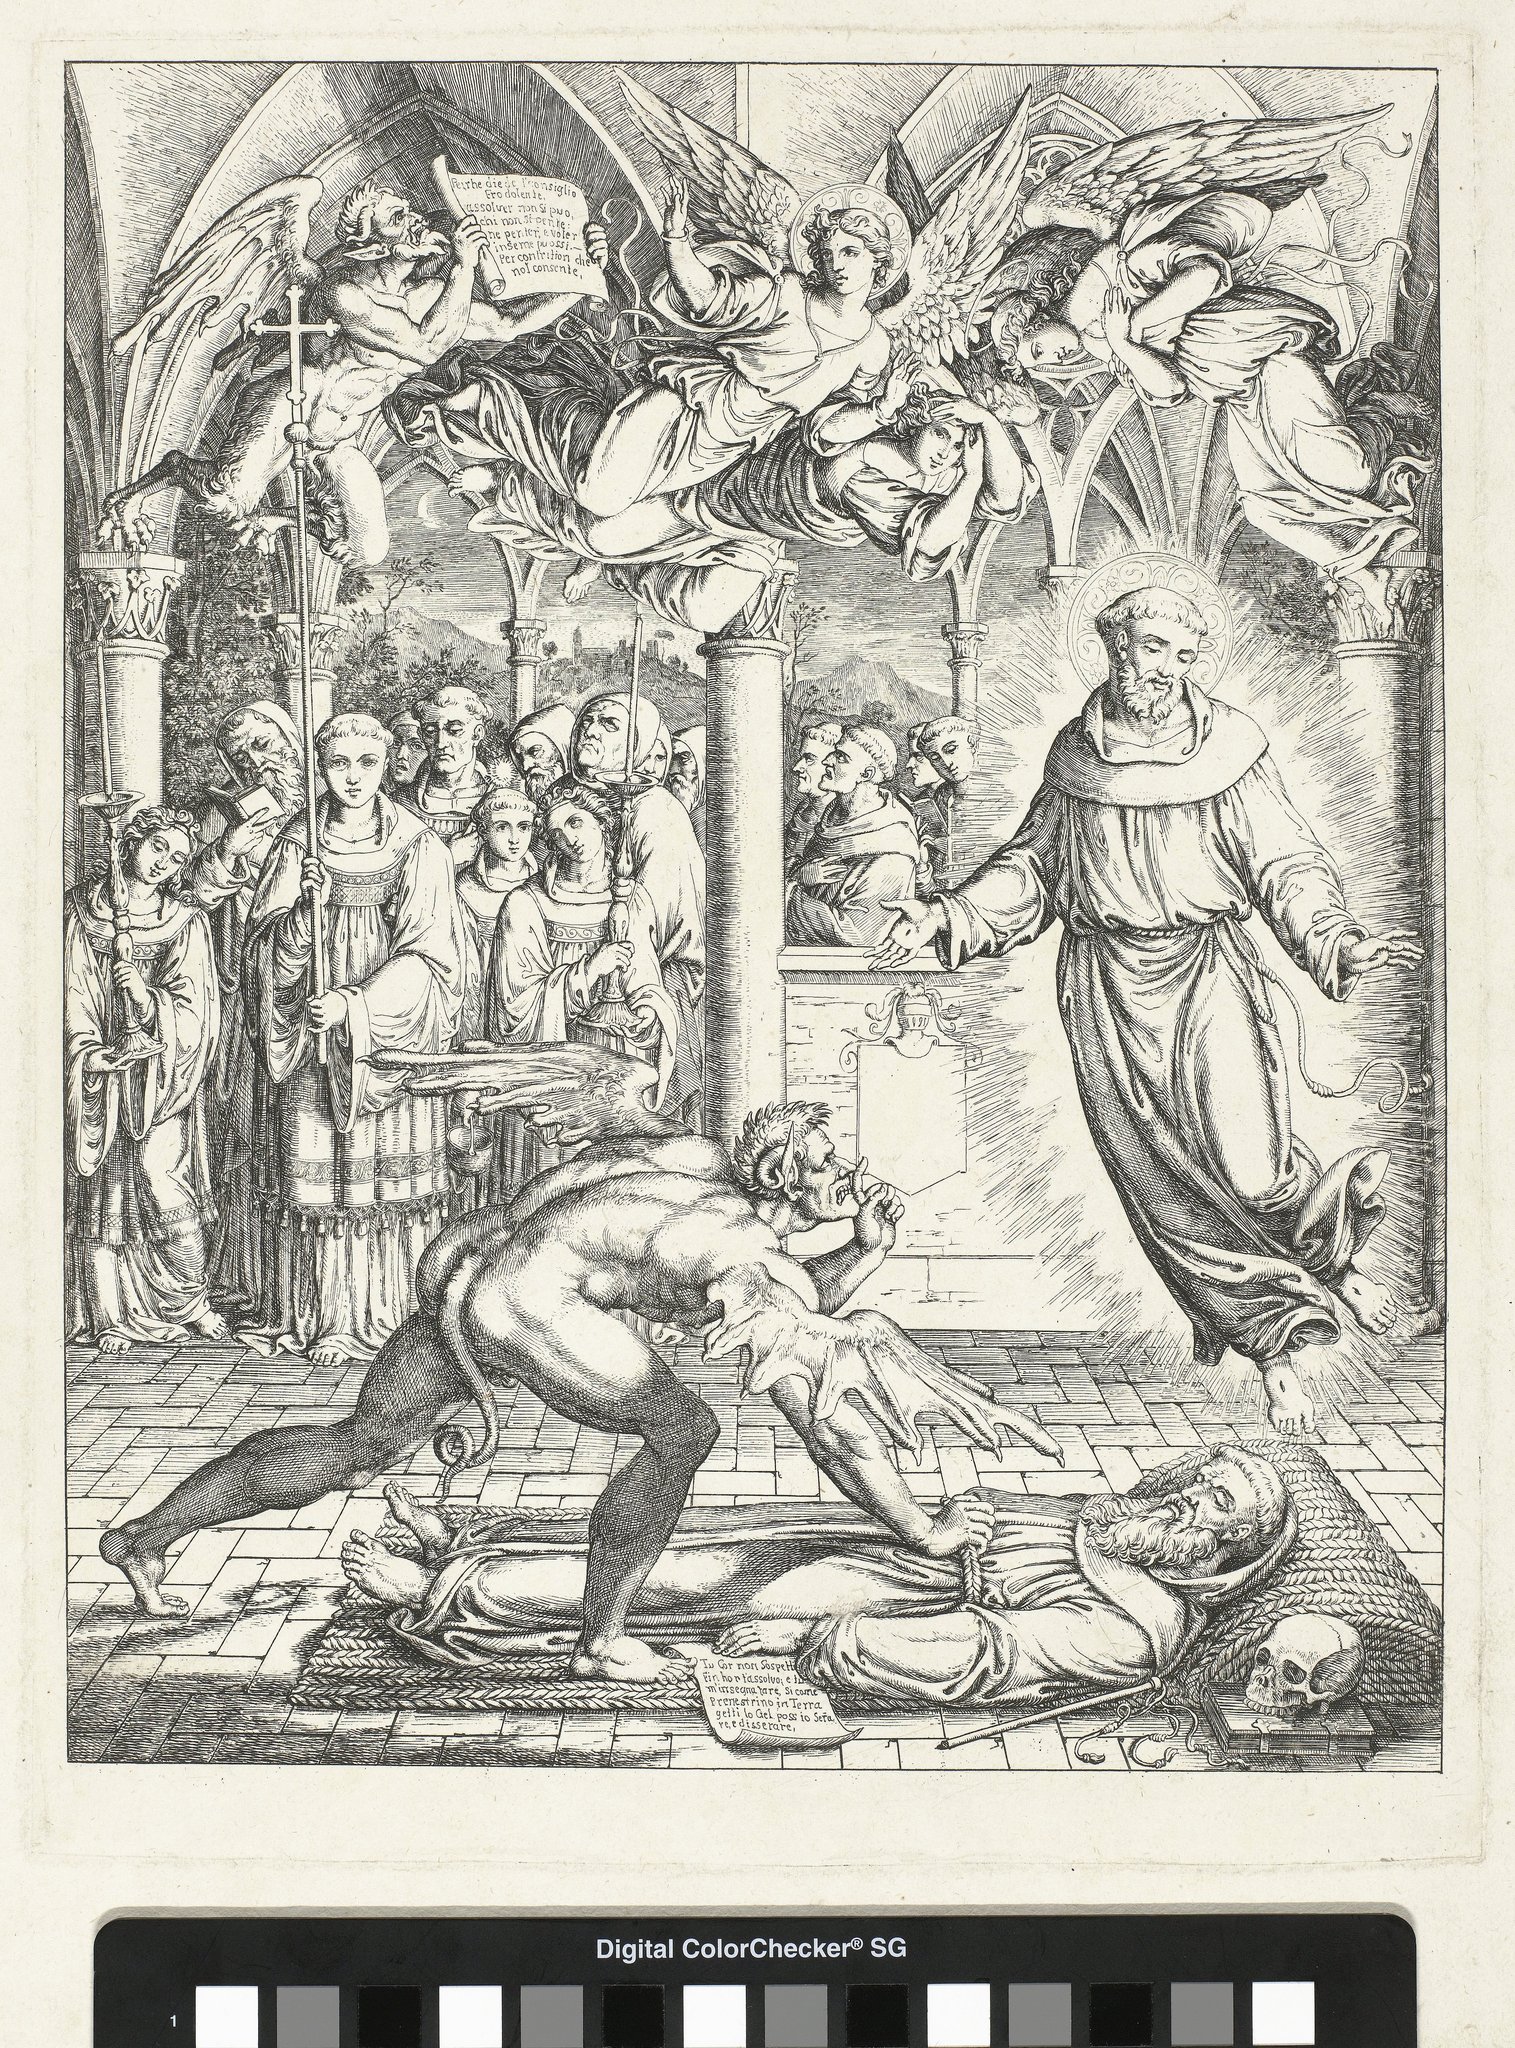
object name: print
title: Guido de Montefeltro gelegen in een kapel met de duivel, de H. Francsicus en een processie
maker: joseph anton koch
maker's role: draughtsman, painter, print maker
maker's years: 1768-1839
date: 1778-1839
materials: paper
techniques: etching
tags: skull as danger signal, cortege, funeral procession, founder of the order of friars minor (franciscans), francis(cus) of assisi; possible attributes: book, crucifix, lily, skull, stigmata, human-shaped devil, angels, (scenes from) specific works of literature: dante, divina commedia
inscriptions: collector's mark: Lugt 2760, collector's mark: Lugt 2228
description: De overleden Guido de Montefeltro, gekleed als Franciscaan, ligt op de grond in een kapel. De duivel grijpt hem bij het koord om zijn middel, rechts de verschijning van de H. Franciscus, beide strijdend om zijn ziel. Op de achtergrond een begrafenisstoet. Tekst in het Italiaans op de twee papieren.